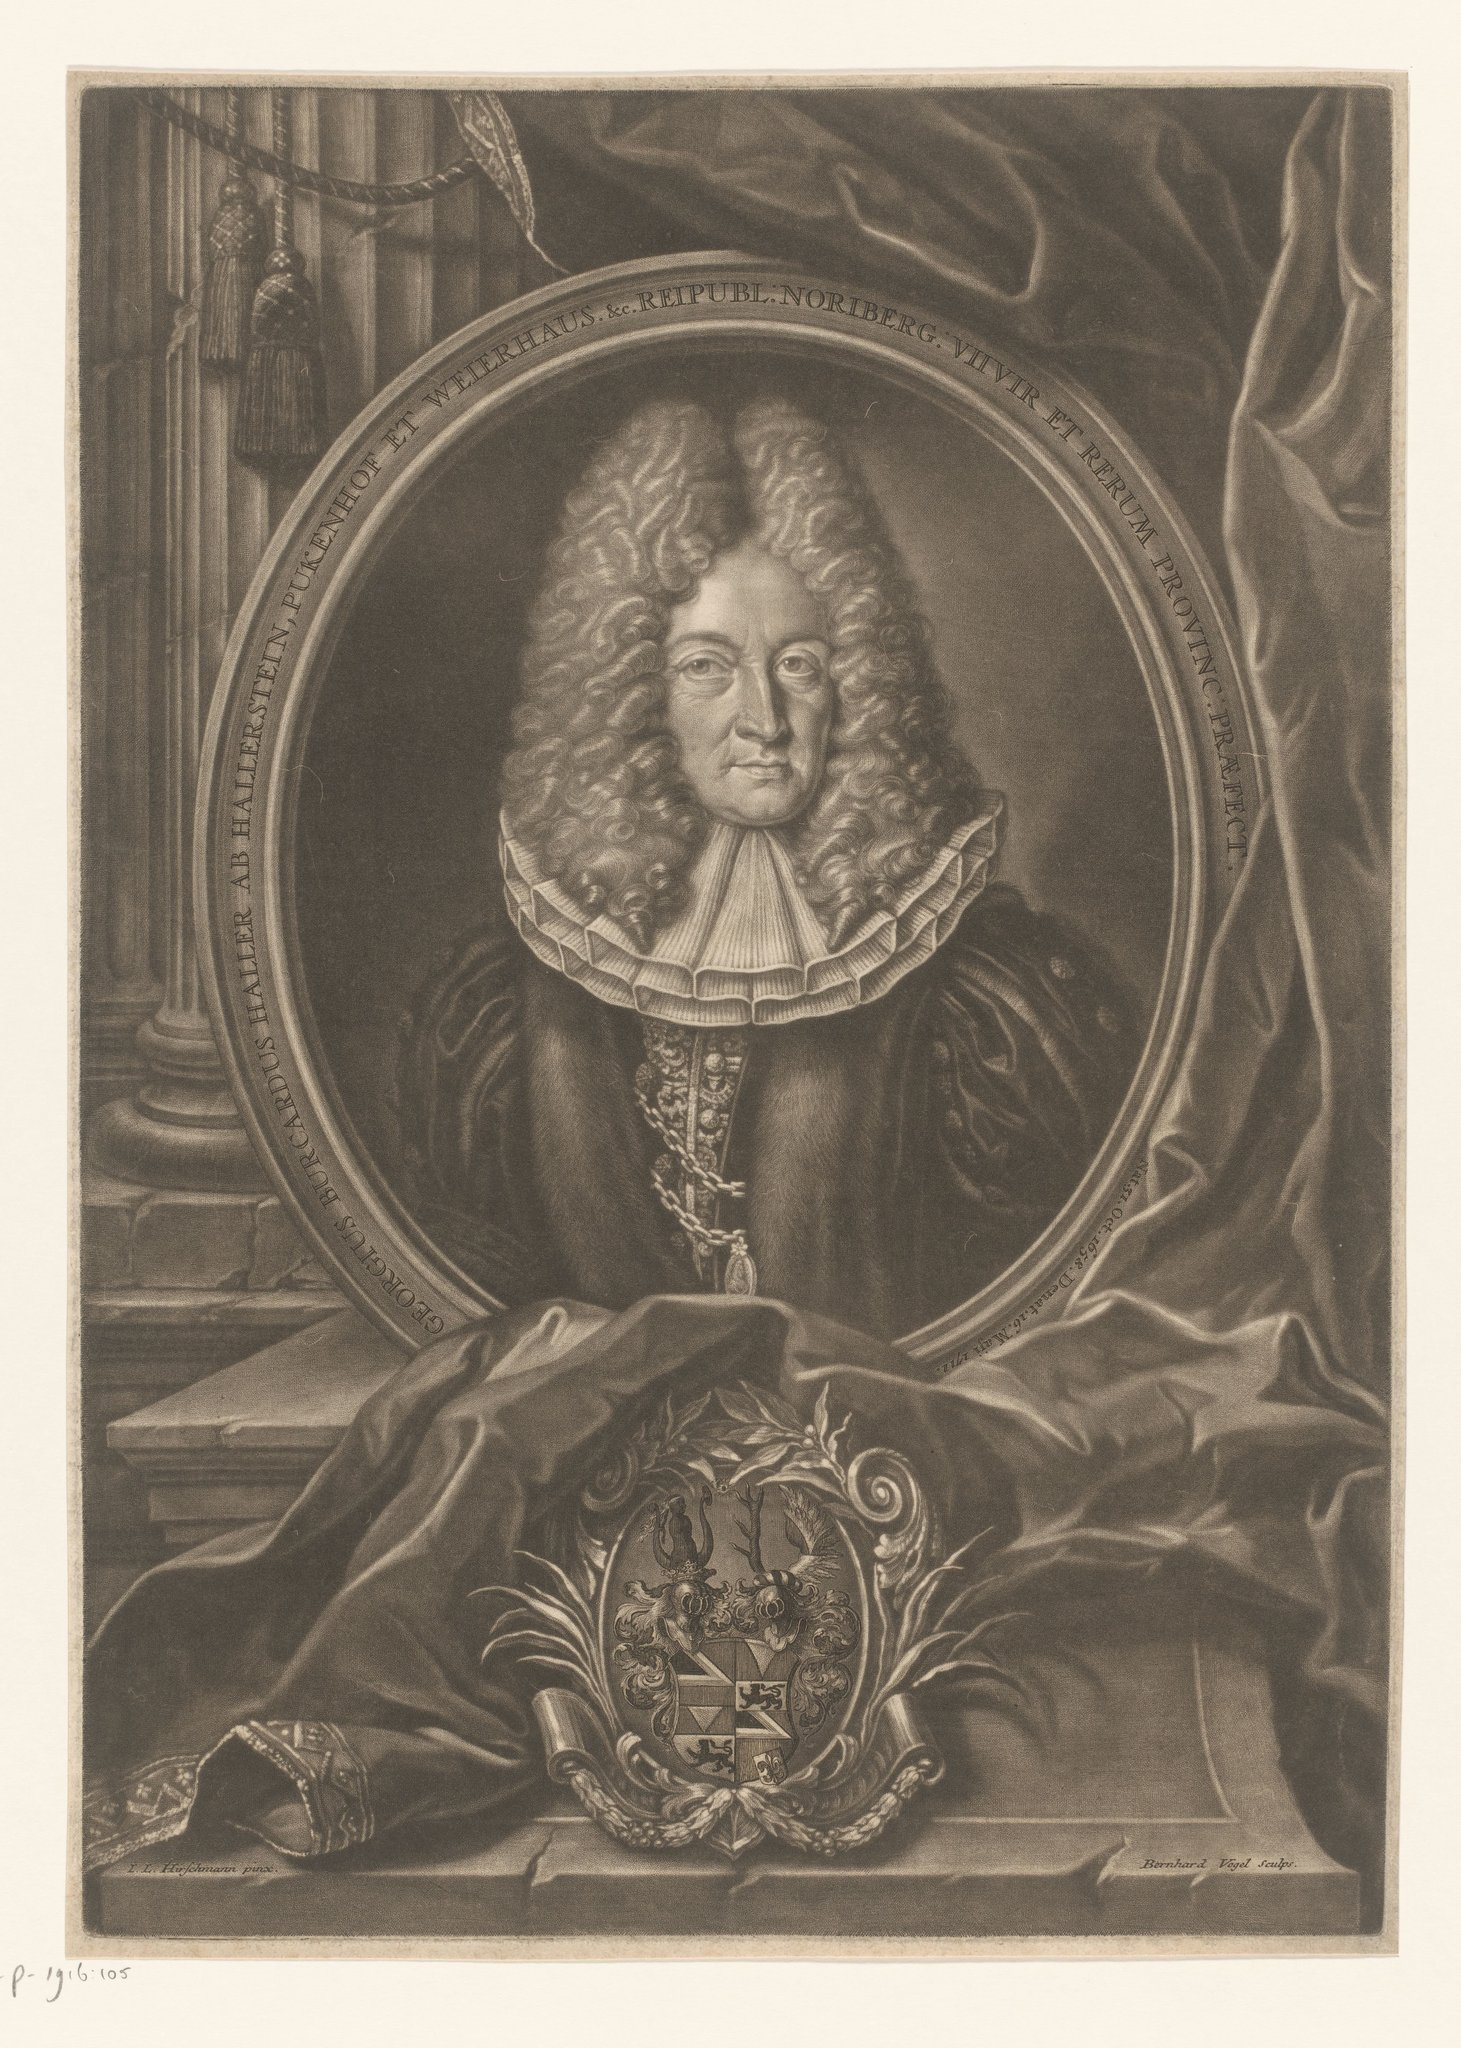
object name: print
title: Portret van Georg Burkhard Haller von Hallerstein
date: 1711-1737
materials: paper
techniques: mezzotint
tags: historical persons, armorial bearing, heraldry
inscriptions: collector's mark: Lugt 2228